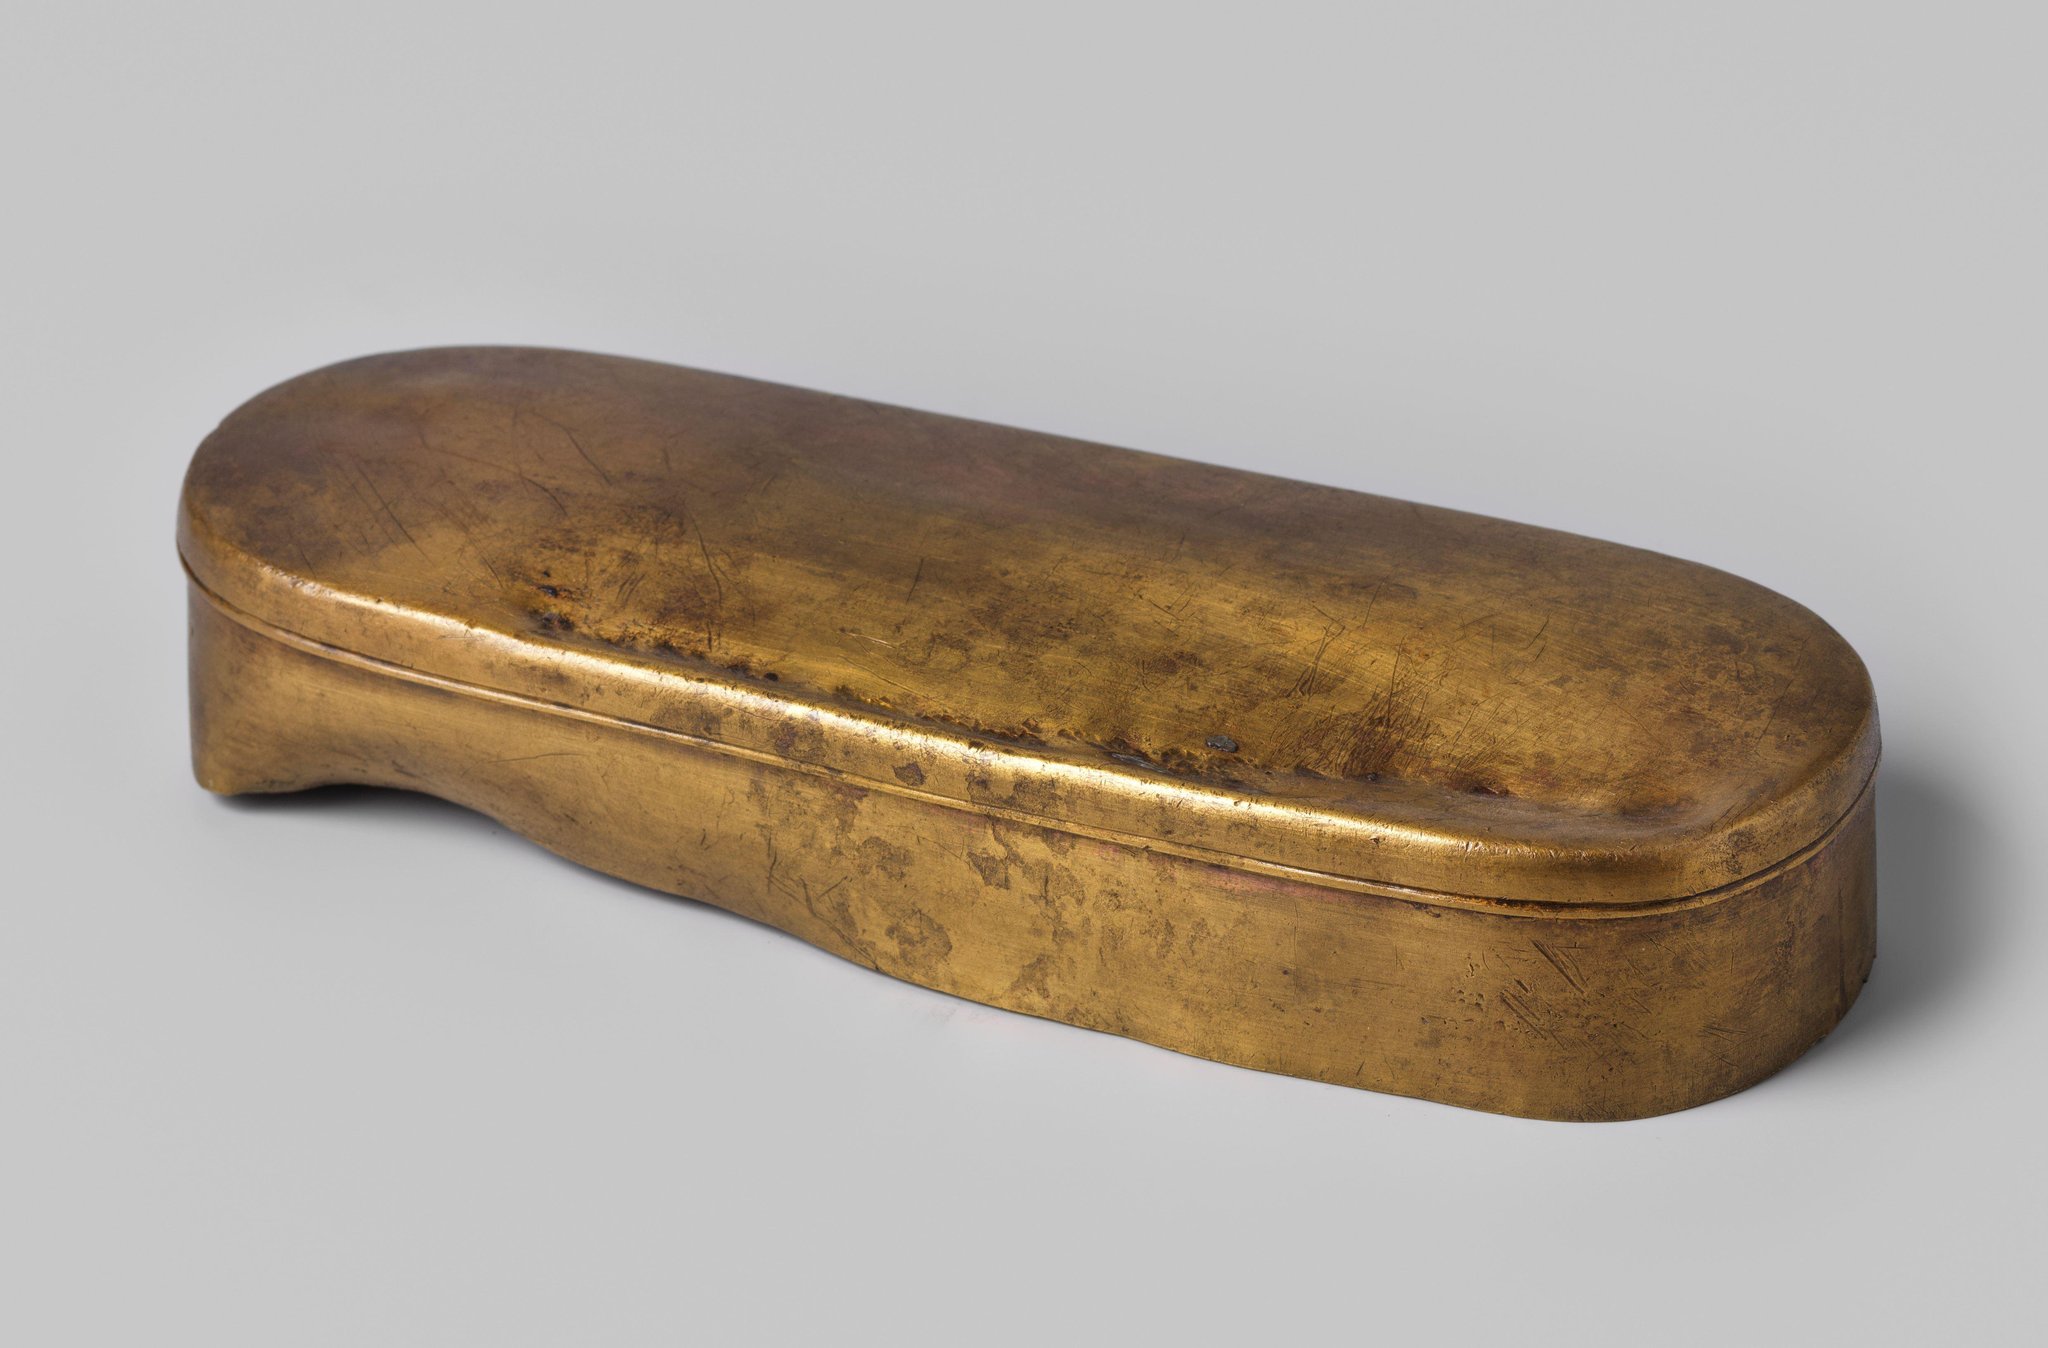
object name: tobacco box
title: Tabaksdoos zonder deksel uit het wrak van de Oost-Indiëvaarder Hollandia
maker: Anonymous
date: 1700-1743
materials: copper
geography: netherlands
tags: verenigde oostindische compagnie, hollandia (schip), annet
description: Tobacco box; fragm, box, oval, flat underside, plain, five-lugged hinge.